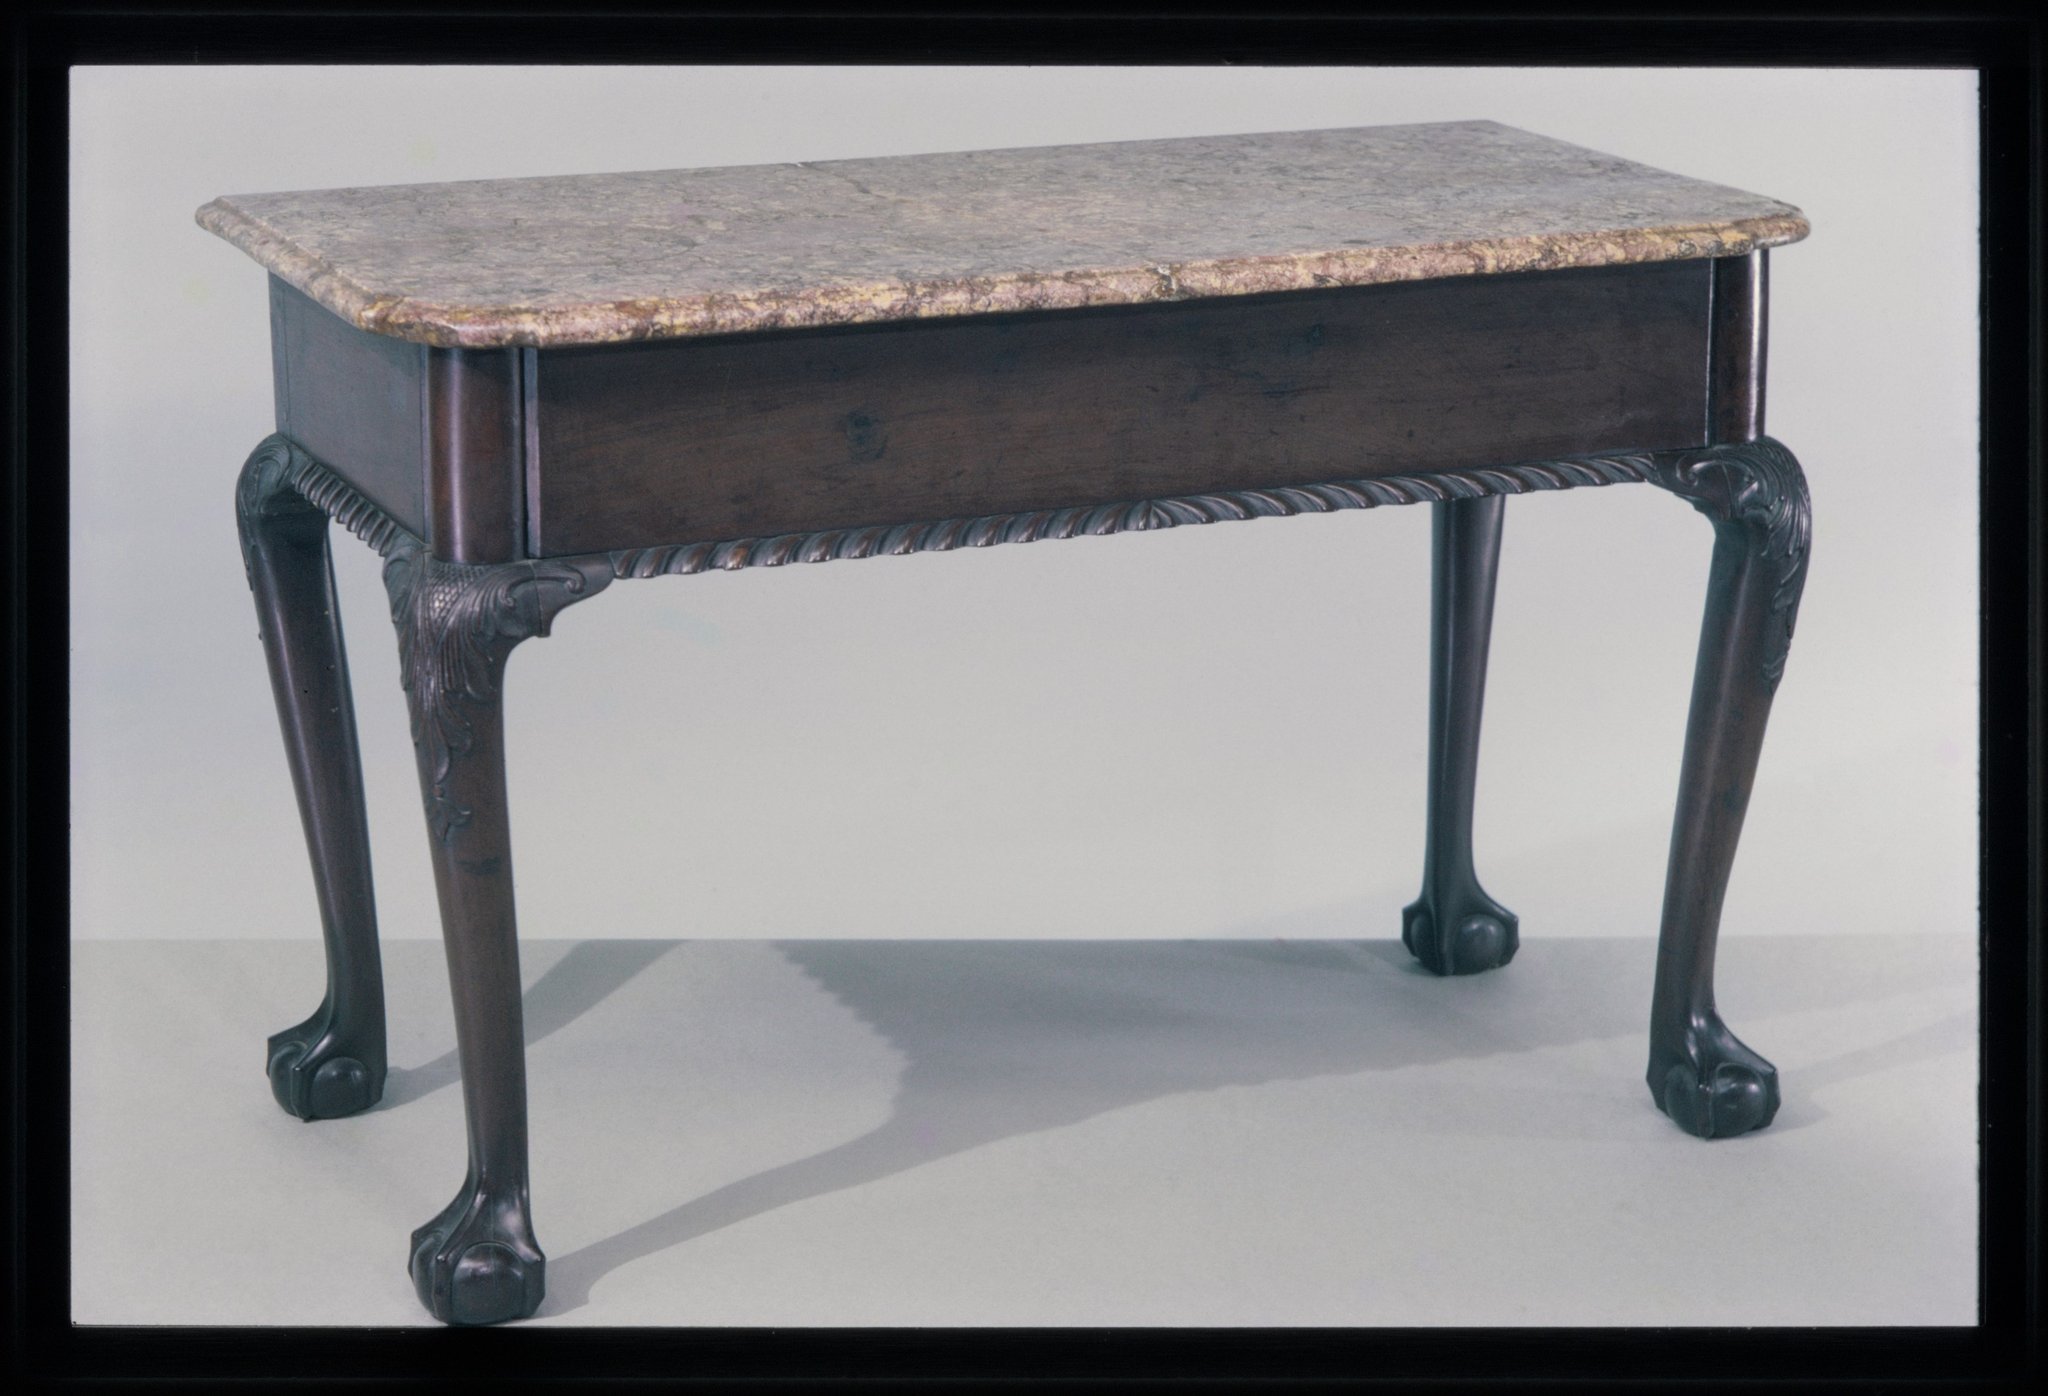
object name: pier table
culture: american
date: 1750-1790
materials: wood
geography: united states